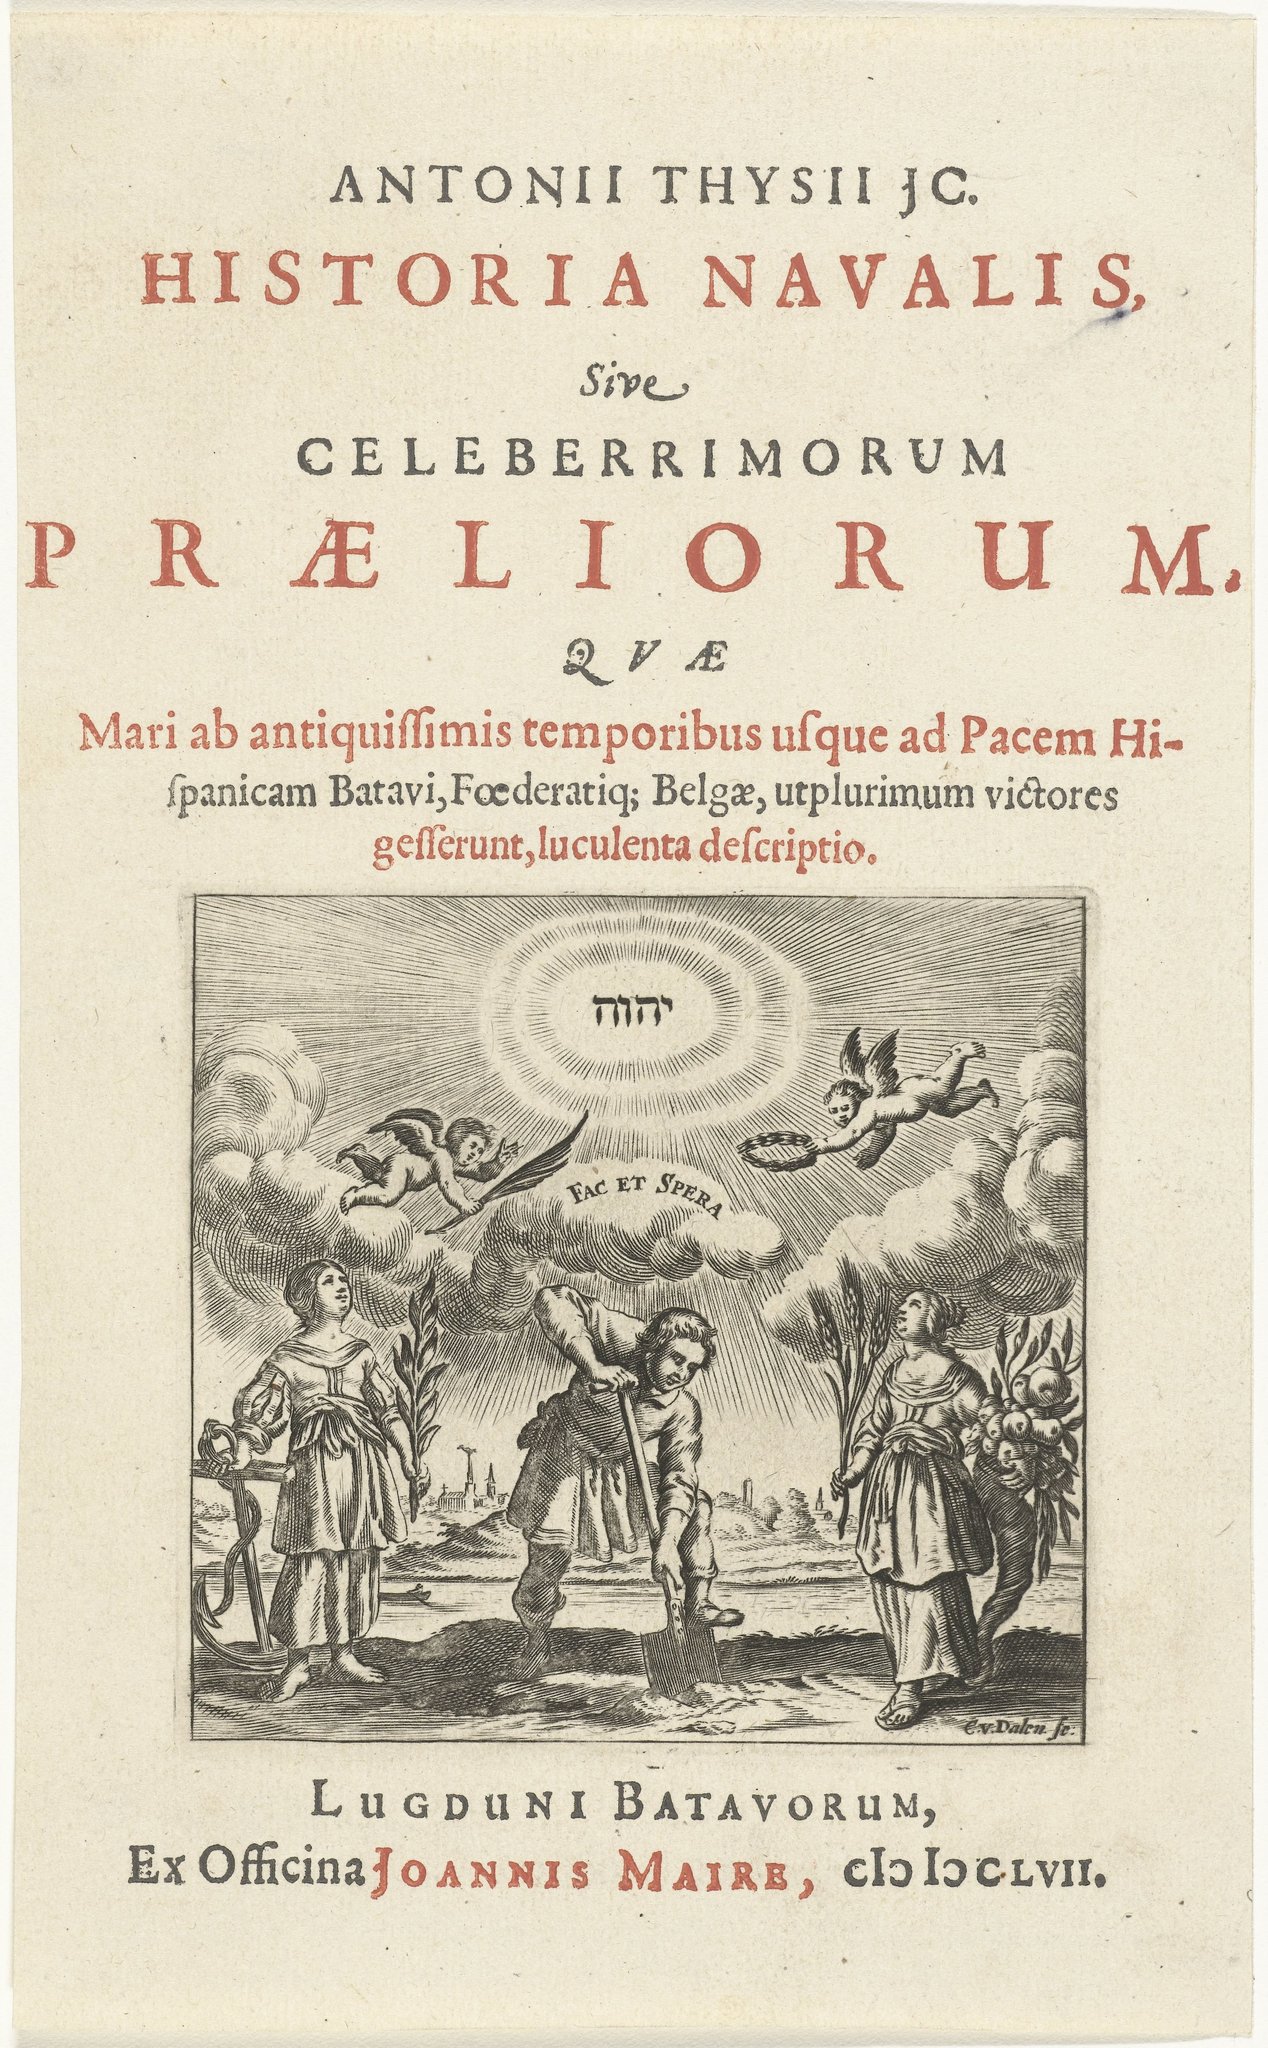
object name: print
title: Titelpagina uit: Historia navalis, sive Celeberrimorum præliorum, Leiden 1657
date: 1657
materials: paper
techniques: engraving, etching, letterpress printing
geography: amsterdam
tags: spading ~ soil cultivation, abundantia (abundance) as roman personification, spes as roman personification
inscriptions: collector's mark: Lugt 2228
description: Titelpagina voor: Antonius Thysius jr., Historia navalis, sive Celeberrimorum præliorum, qvæ mari ab antiquissimis temporibus usque ad pacem Hispanicam Batavi, Fœderatiq; Belgæ, ut plurimum victores gesserunt, luculenta descriptio, Joannes Maire (uitgever), Leiden 1657